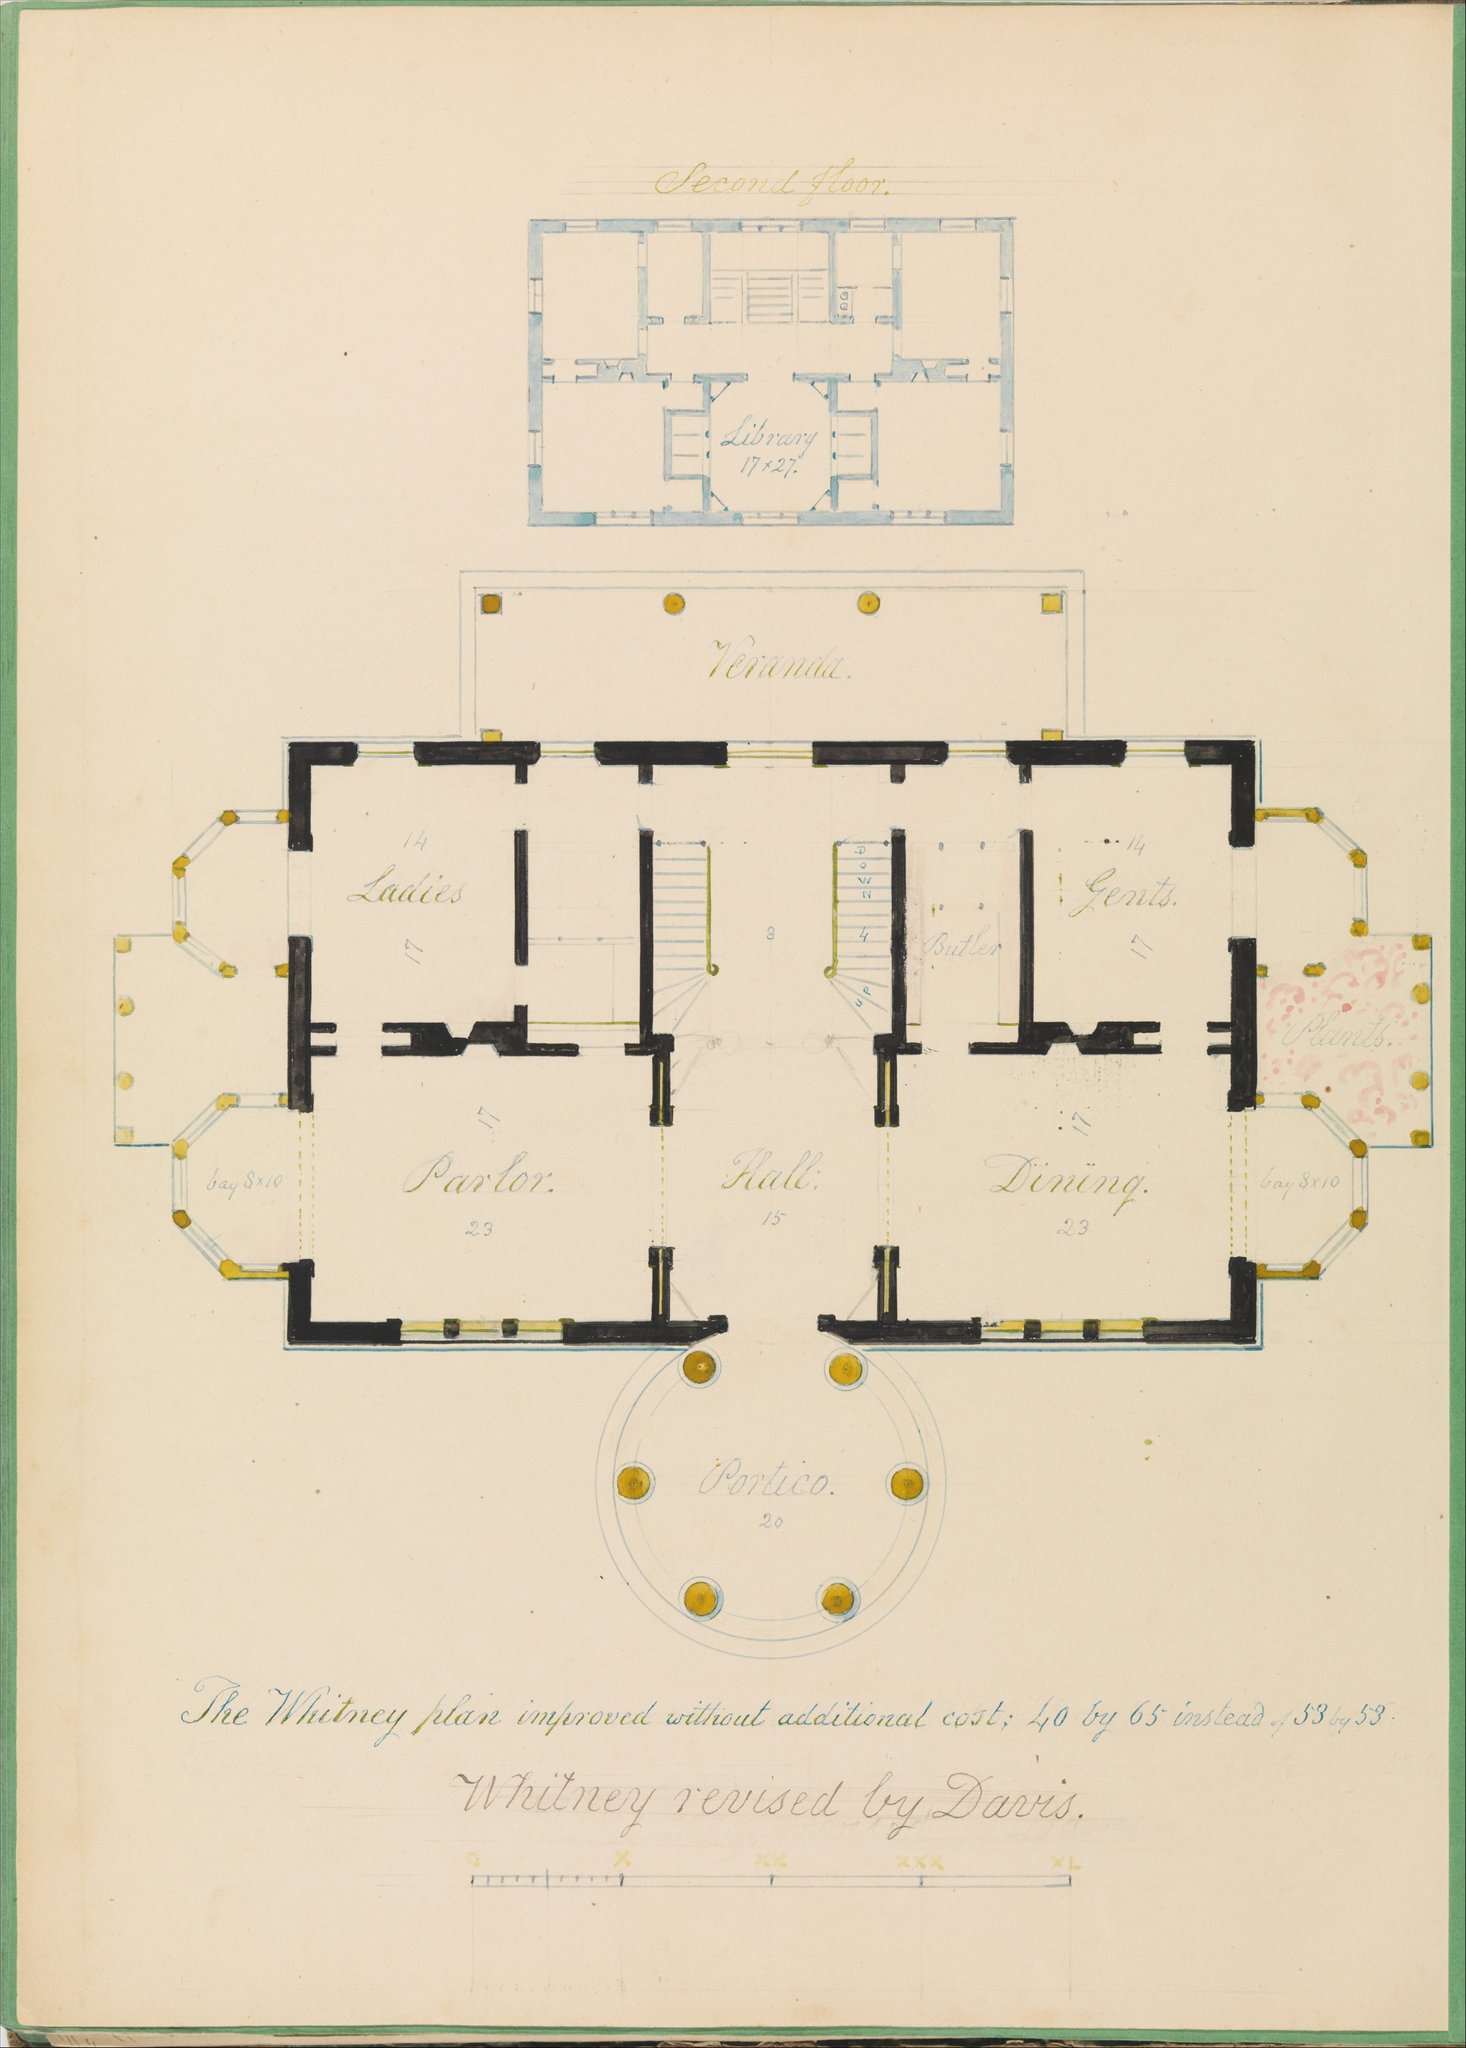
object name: drawing ornament architecture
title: House for Henry Whitney, New Haven, Connecticut (revised plan)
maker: alexander jackson davis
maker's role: artist and architect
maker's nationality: american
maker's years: 1803-1892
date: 1836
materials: graphite, ink, watercolor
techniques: pen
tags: architecture,houses